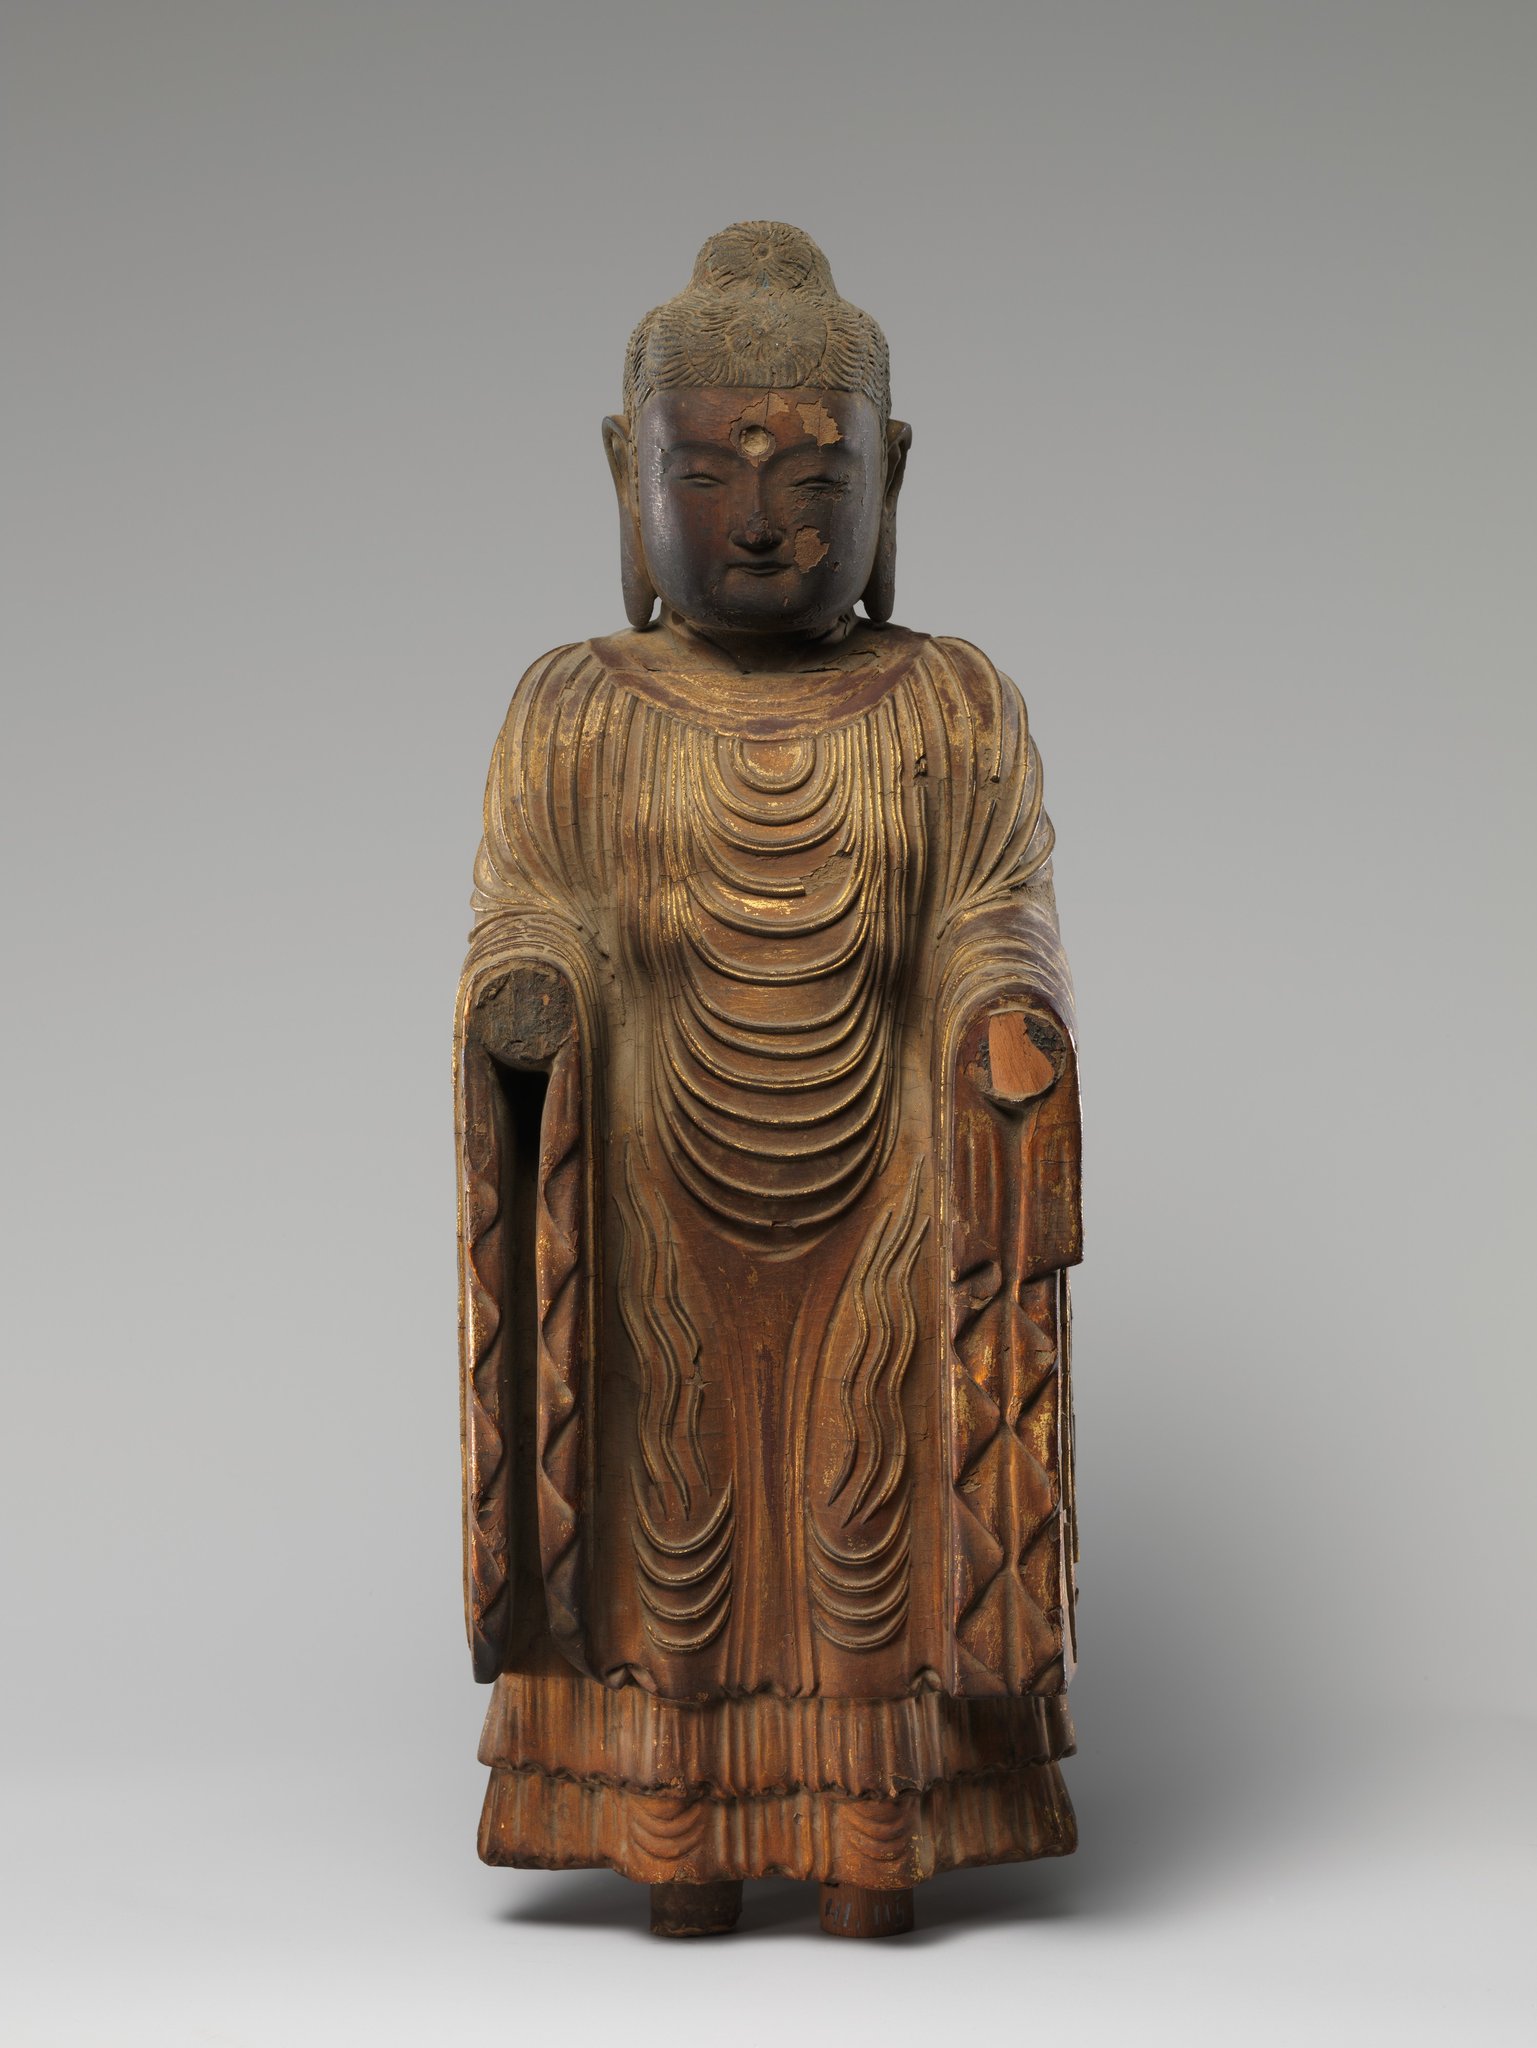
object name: figure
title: Udyana, Image of Buddha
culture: chinese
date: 1368-1644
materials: wood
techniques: polychrome